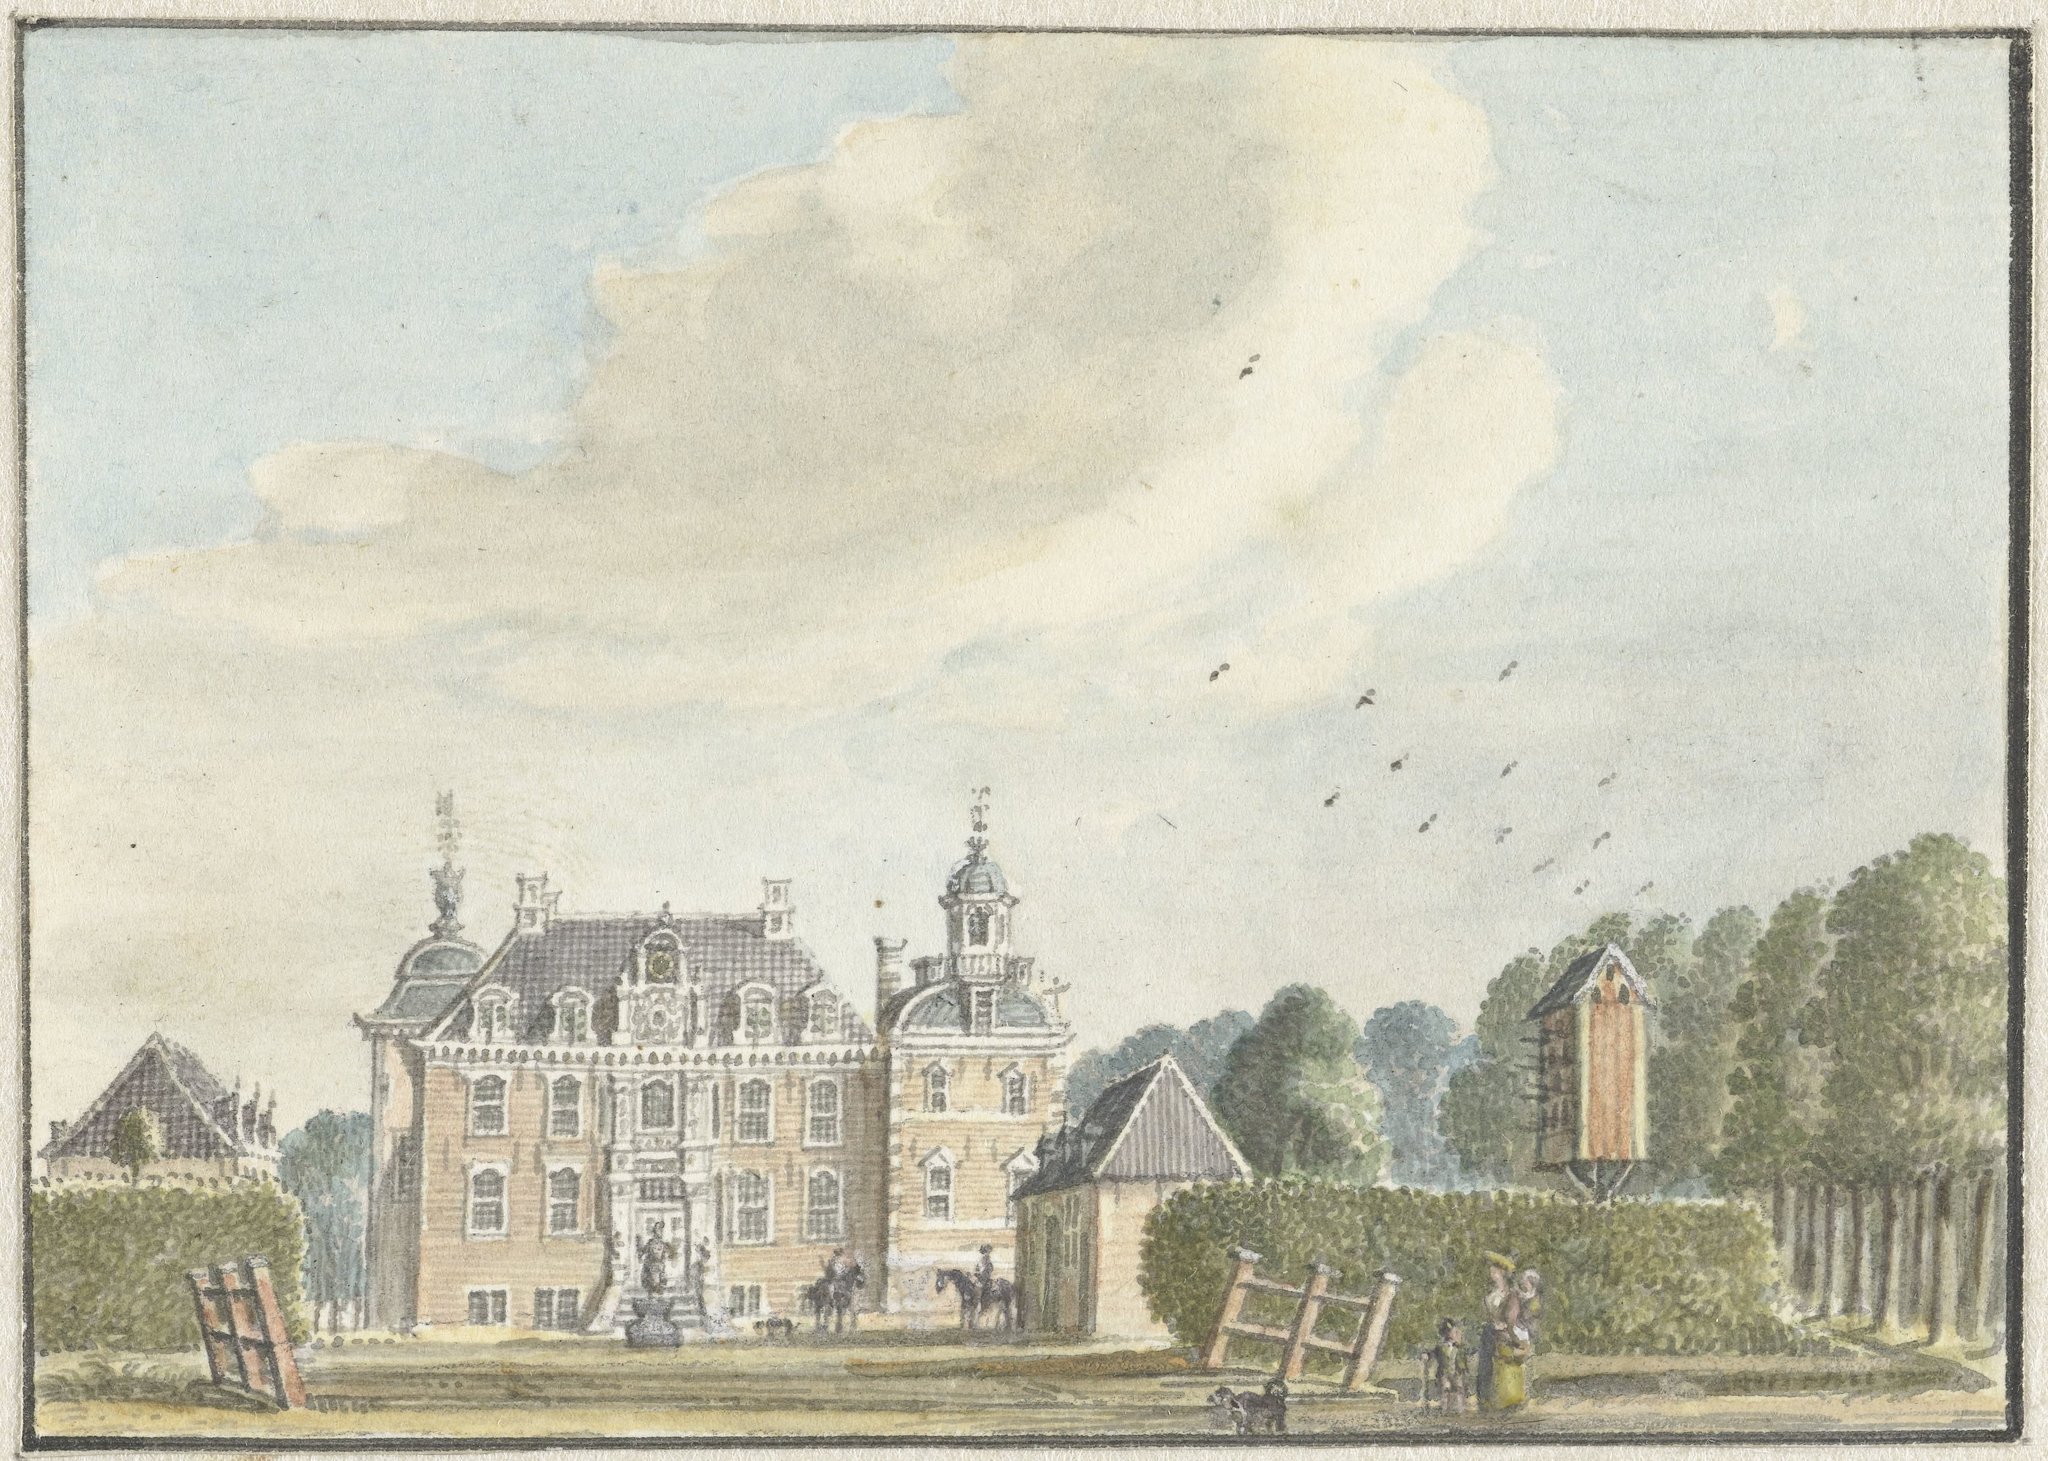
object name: drawing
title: Het Huis Rooderloo bij Ruurlo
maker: jan de beijer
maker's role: draughtsman, print maker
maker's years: 1703-1780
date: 1743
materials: ink, paper, watercolor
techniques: brush, pen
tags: castle